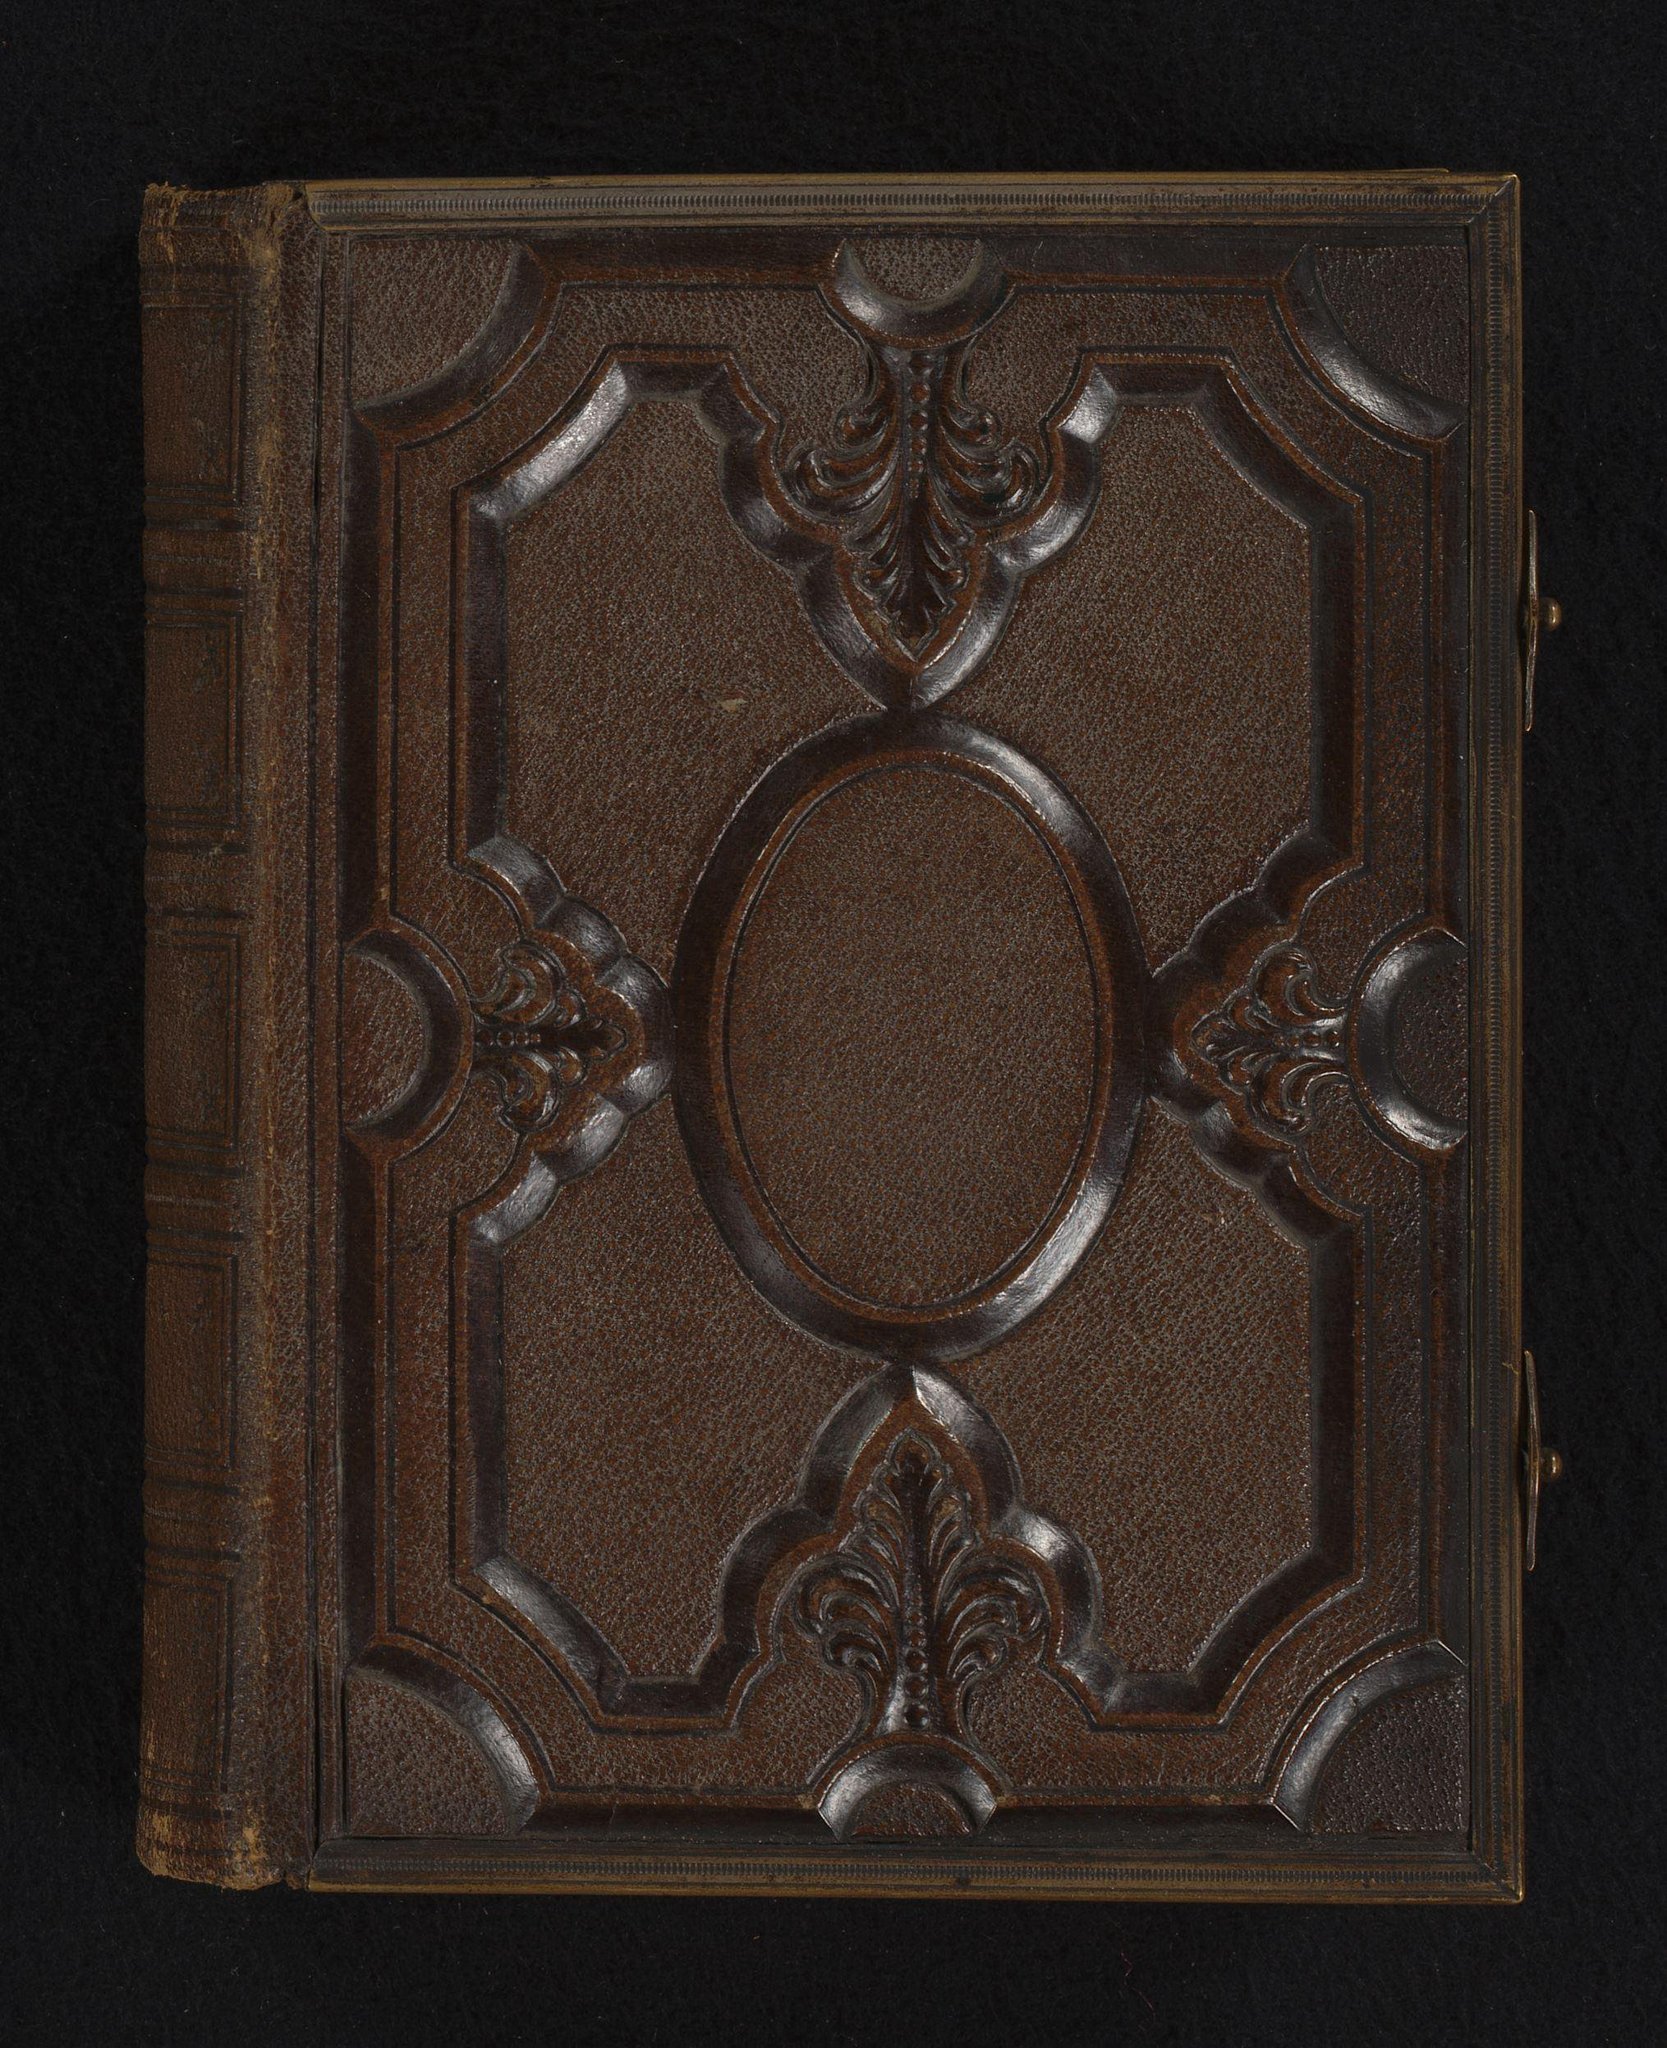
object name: slip in album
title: Fotoalbum (leeg)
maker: Anonymous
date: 1860-1900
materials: cardboard, leather, metal, paper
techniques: color on snow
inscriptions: collector's mark: ‘DIENST/ VERSPREIDE/ RIJKSKOLLEKTIES/ (...) A 778’, inscription: ‘K cdt’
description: Fotoalbum met 25 bladen met aan weerszijden een passe-partout voor een carte-de-visite.